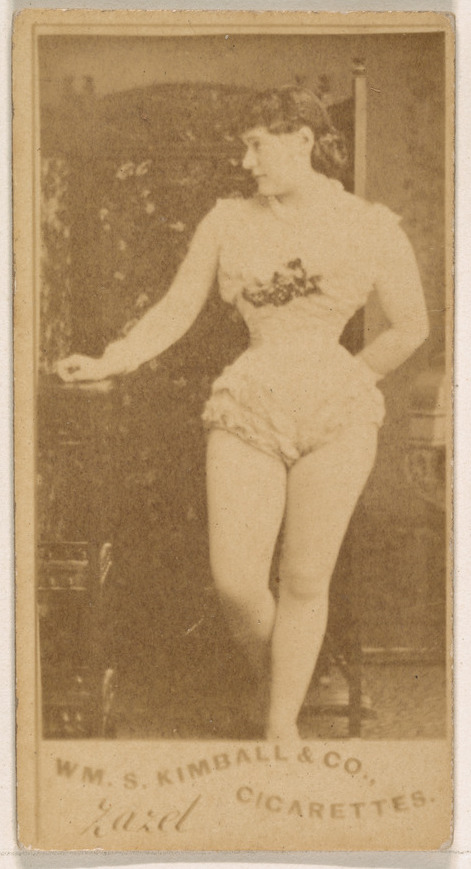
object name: photograph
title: Miss Zazel, from the Actresses series (N203) issued by Wm. S. Kimball & Co.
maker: william s. kimball & company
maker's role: publisher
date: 1889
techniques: color lithograph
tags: portraits,women,actresses